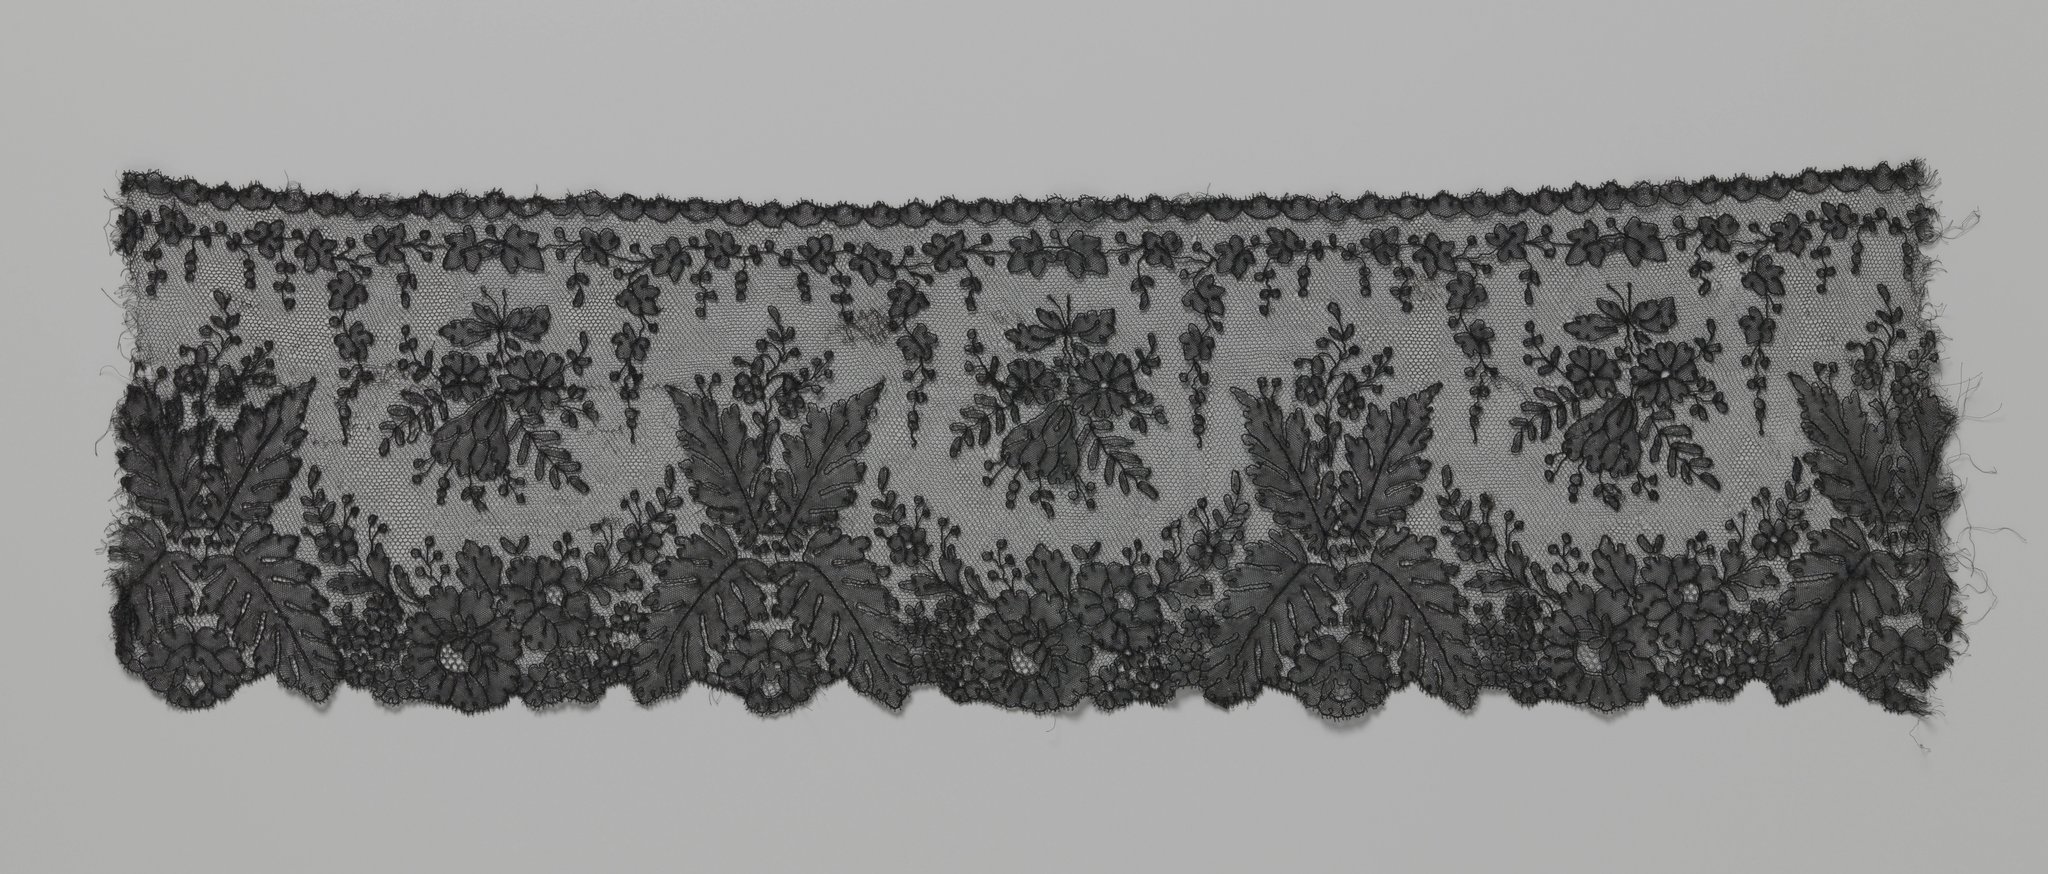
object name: strip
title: Japonstrook van kloskant met varens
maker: Anonymous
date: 1850-1855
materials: silk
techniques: lace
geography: france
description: Japonstrook van zwarte kloskant: Chantilly-kant. Op een leeg mazenfond staat een gesloten rand met schulpen, gevuld met een guirlande van bloemen en bladeren. Op de snijpunten staat een kleine schulp met een hangende roos, waarboven een spits boeket oprijst van vier grote varenbladeren en een bloemtak, die tot aan de bovenrand reikt. Hier loopt een horizontale klimoprank met hangende takjes, terwijl op het veld boven de grote schulp van deze klimoprank een groot boeket afhangt, onder andere met een tulp.